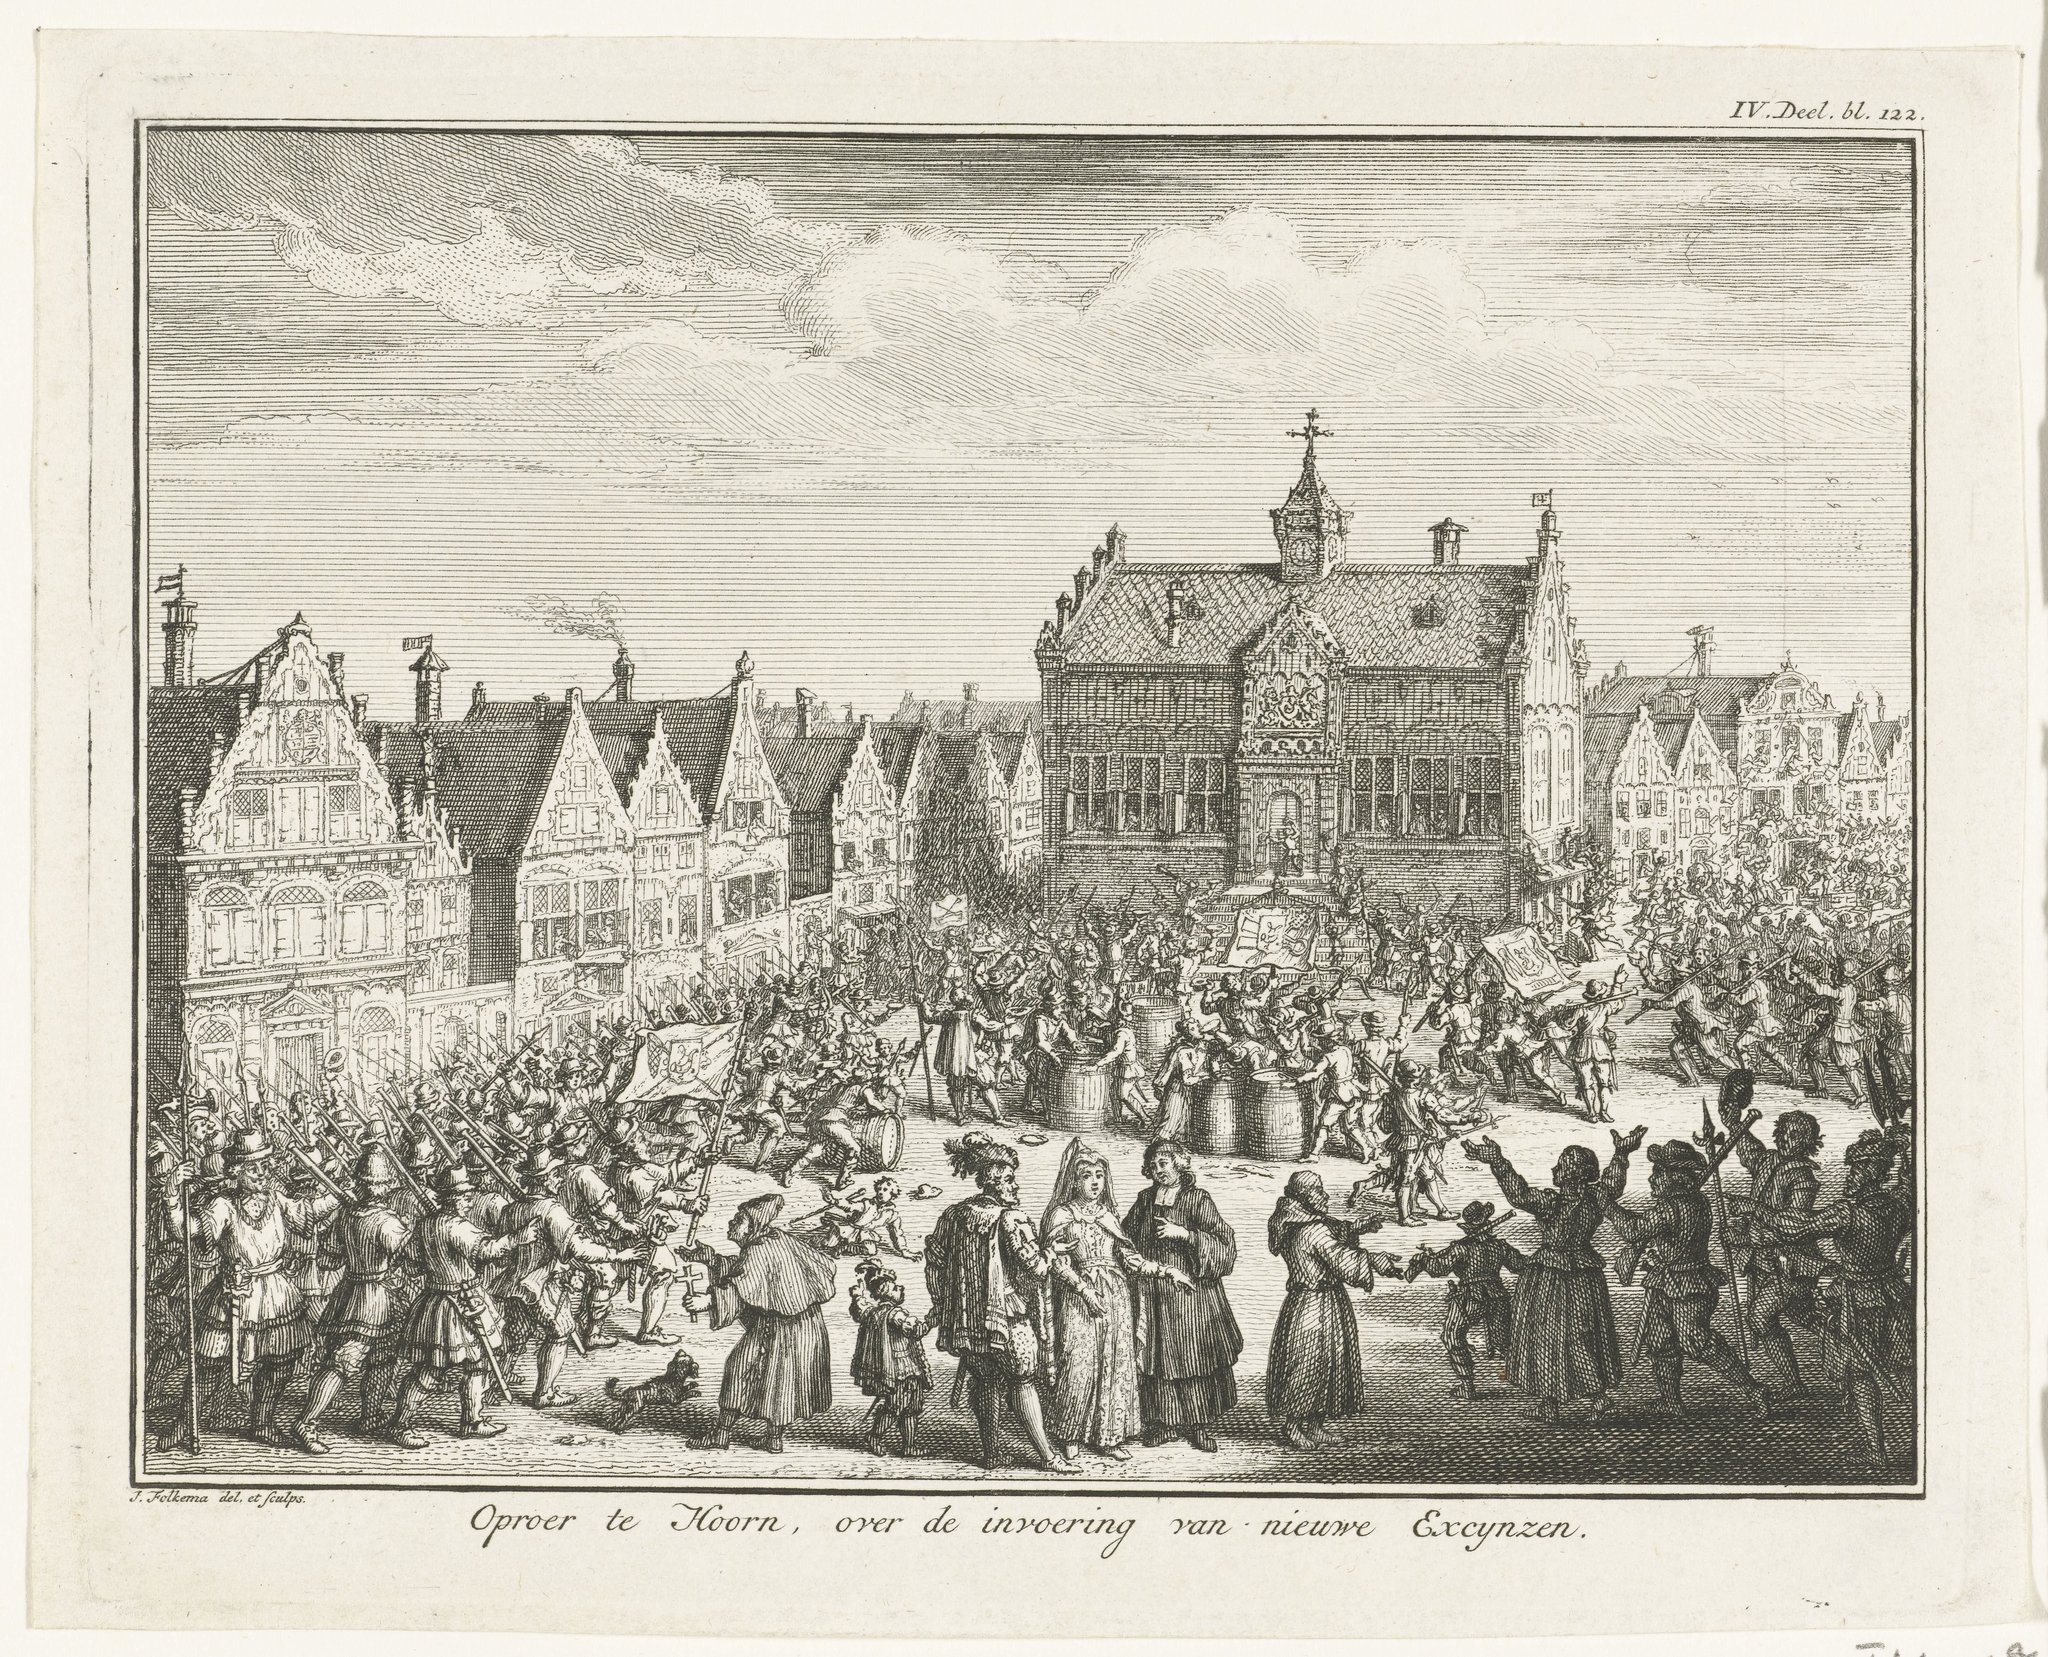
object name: print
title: Oproer te Hoorn, over de invoering van nieuwe Excynzen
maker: jacob folkema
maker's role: draughtsman, print maker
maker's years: 1692-1767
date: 1747-1759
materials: paper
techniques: etching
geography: northern netherlands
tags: earl, charles the bold (duke of burgundy), street-fights, riots, taxes and financial administration, hoorn (north holland), burgundian netherlands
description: Oproer te Hoorn over de invoering door Karel de Stoute van nieuwe accijnzen op het bier, 21 mei 1470. Volksmenigte voor het stadhuis slaat vaten bier open, links en rechts komen soldaten aangesneld.